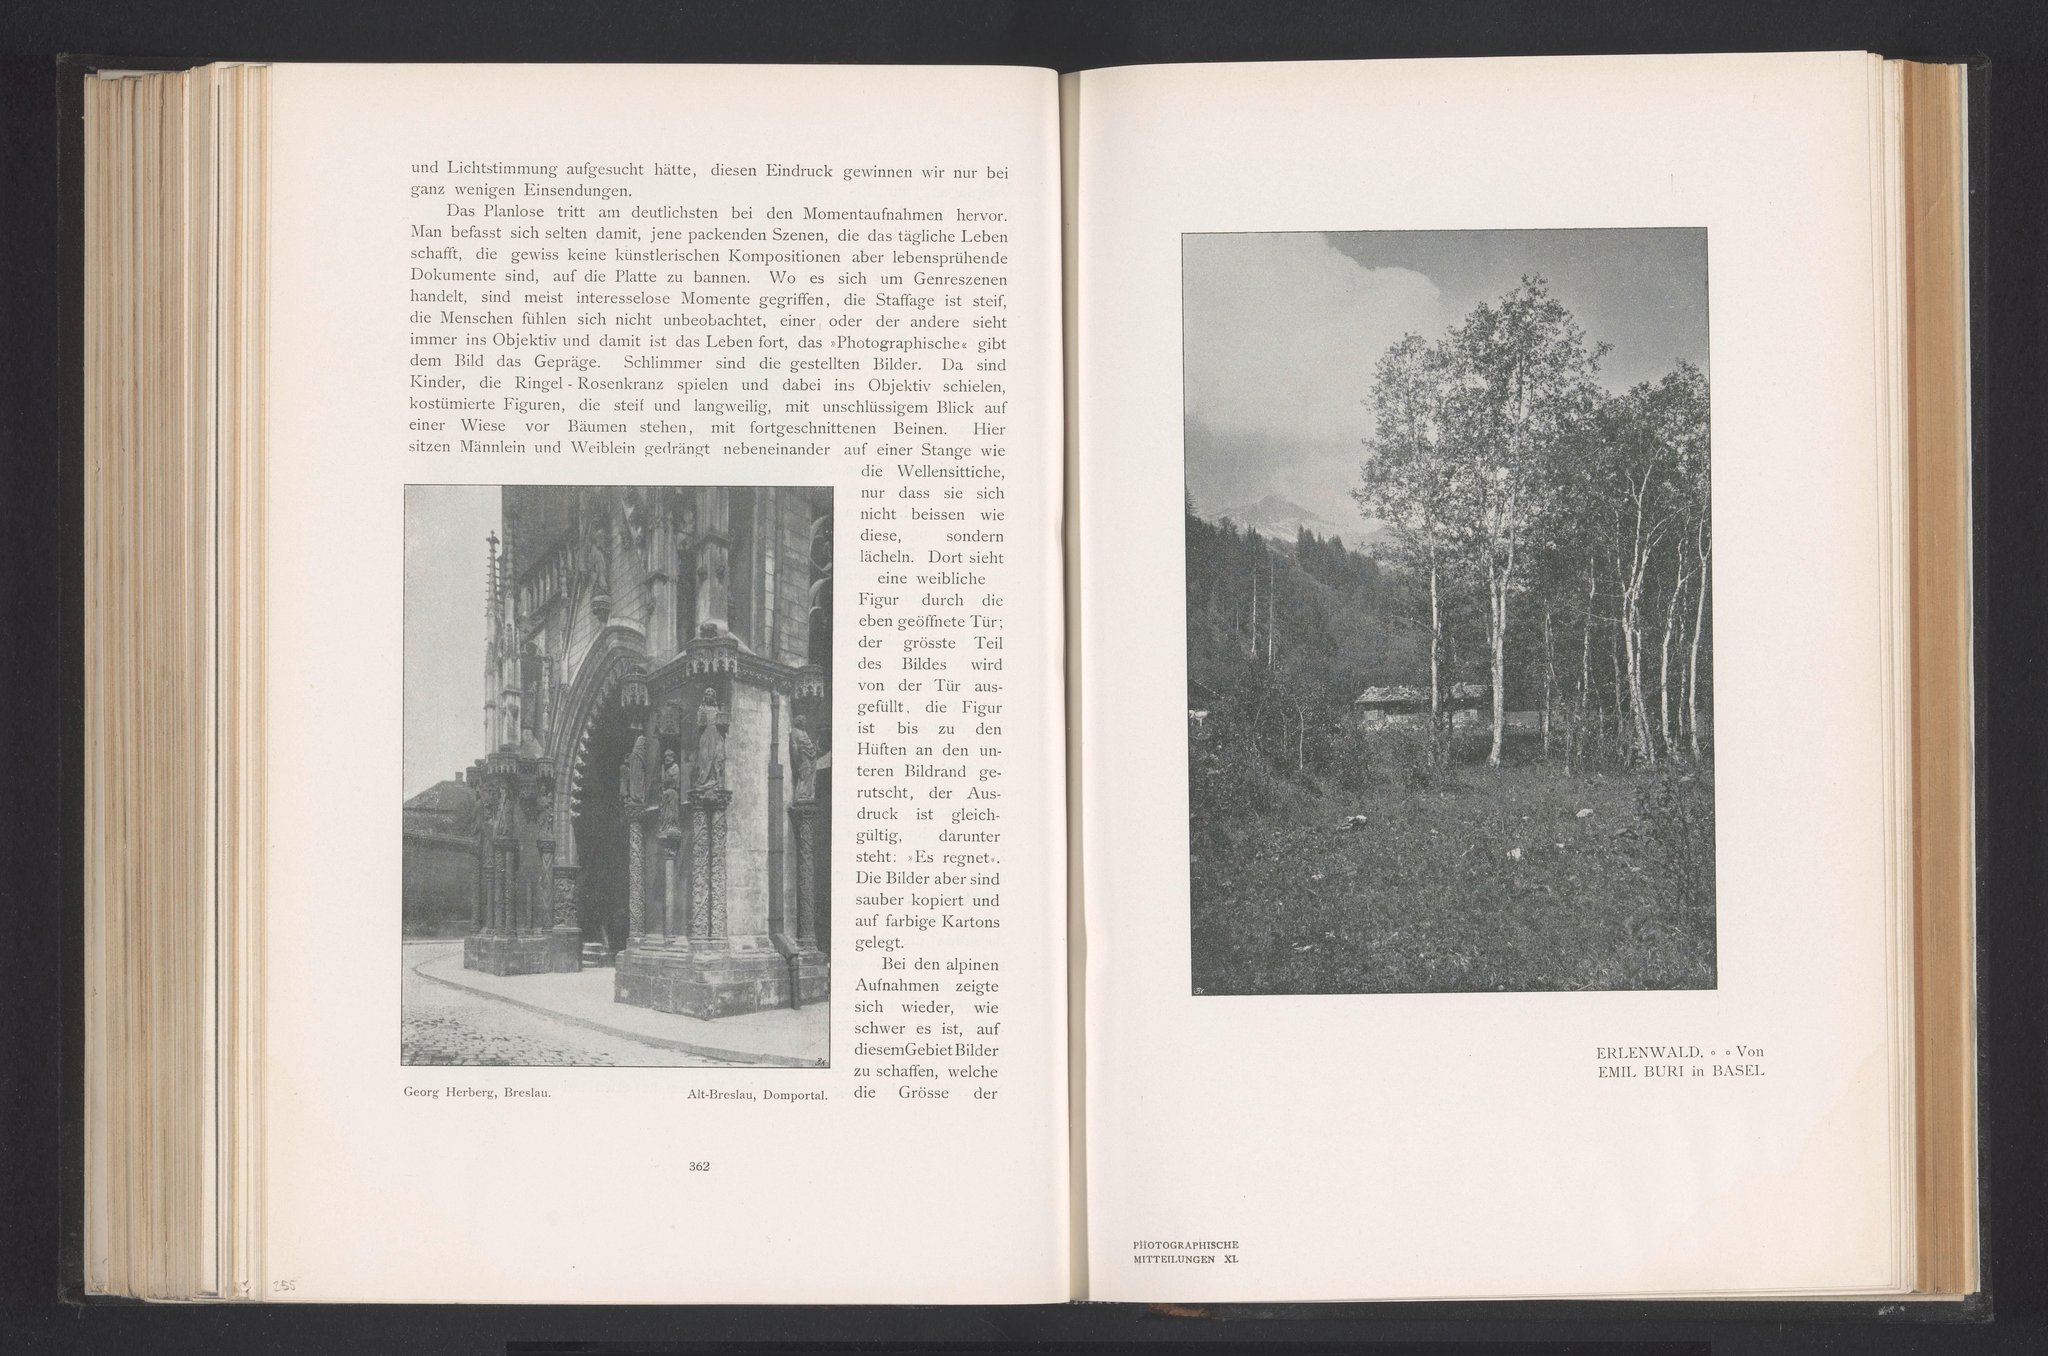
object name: photomechanical print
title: Alt-Breslau, Domportal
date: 1898-1903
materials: paper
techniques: autotype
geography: wroclaw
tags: parts of church exterior and annexes: portal, church (exterior)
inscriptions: monogram: ‘BX’